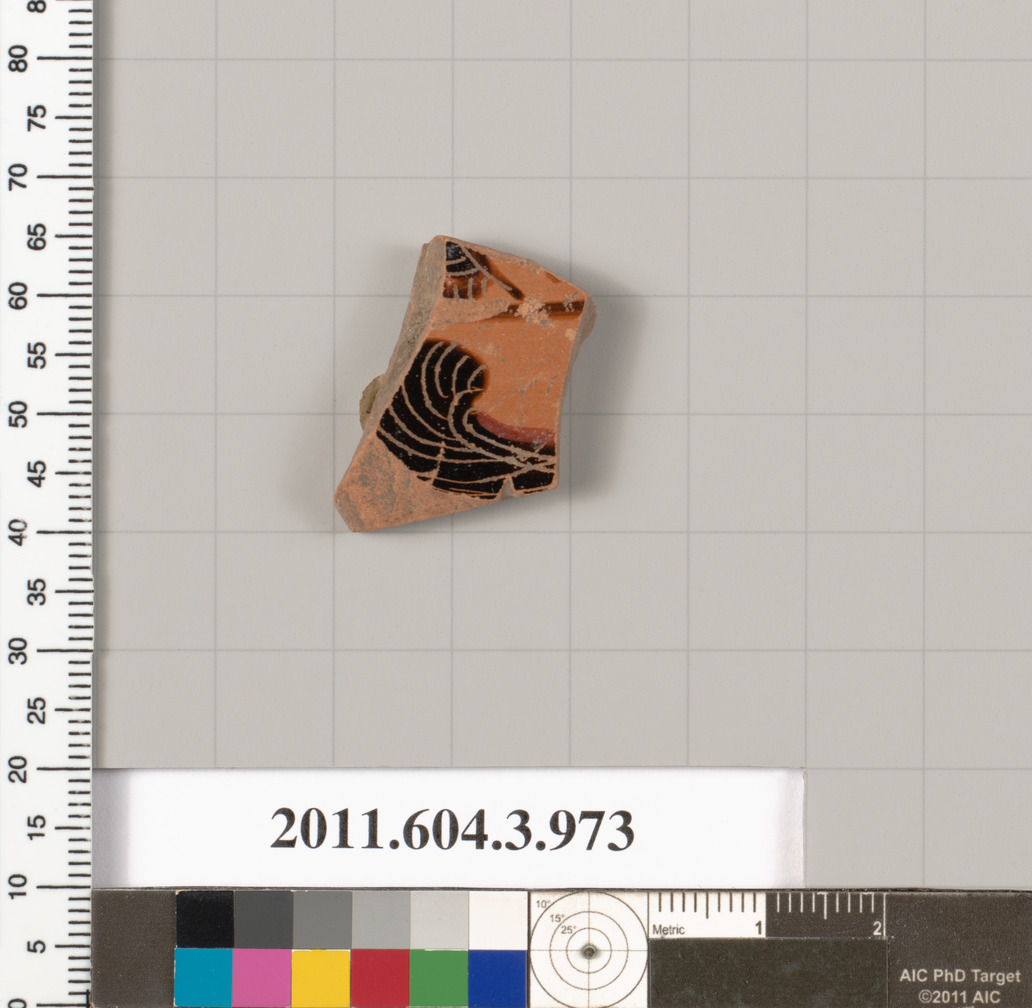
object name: lekanis lid fragment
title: Terracotta fragment of a lekanis lid (covered dish)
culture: greek, attic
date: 575-551 BCE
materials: terracotta